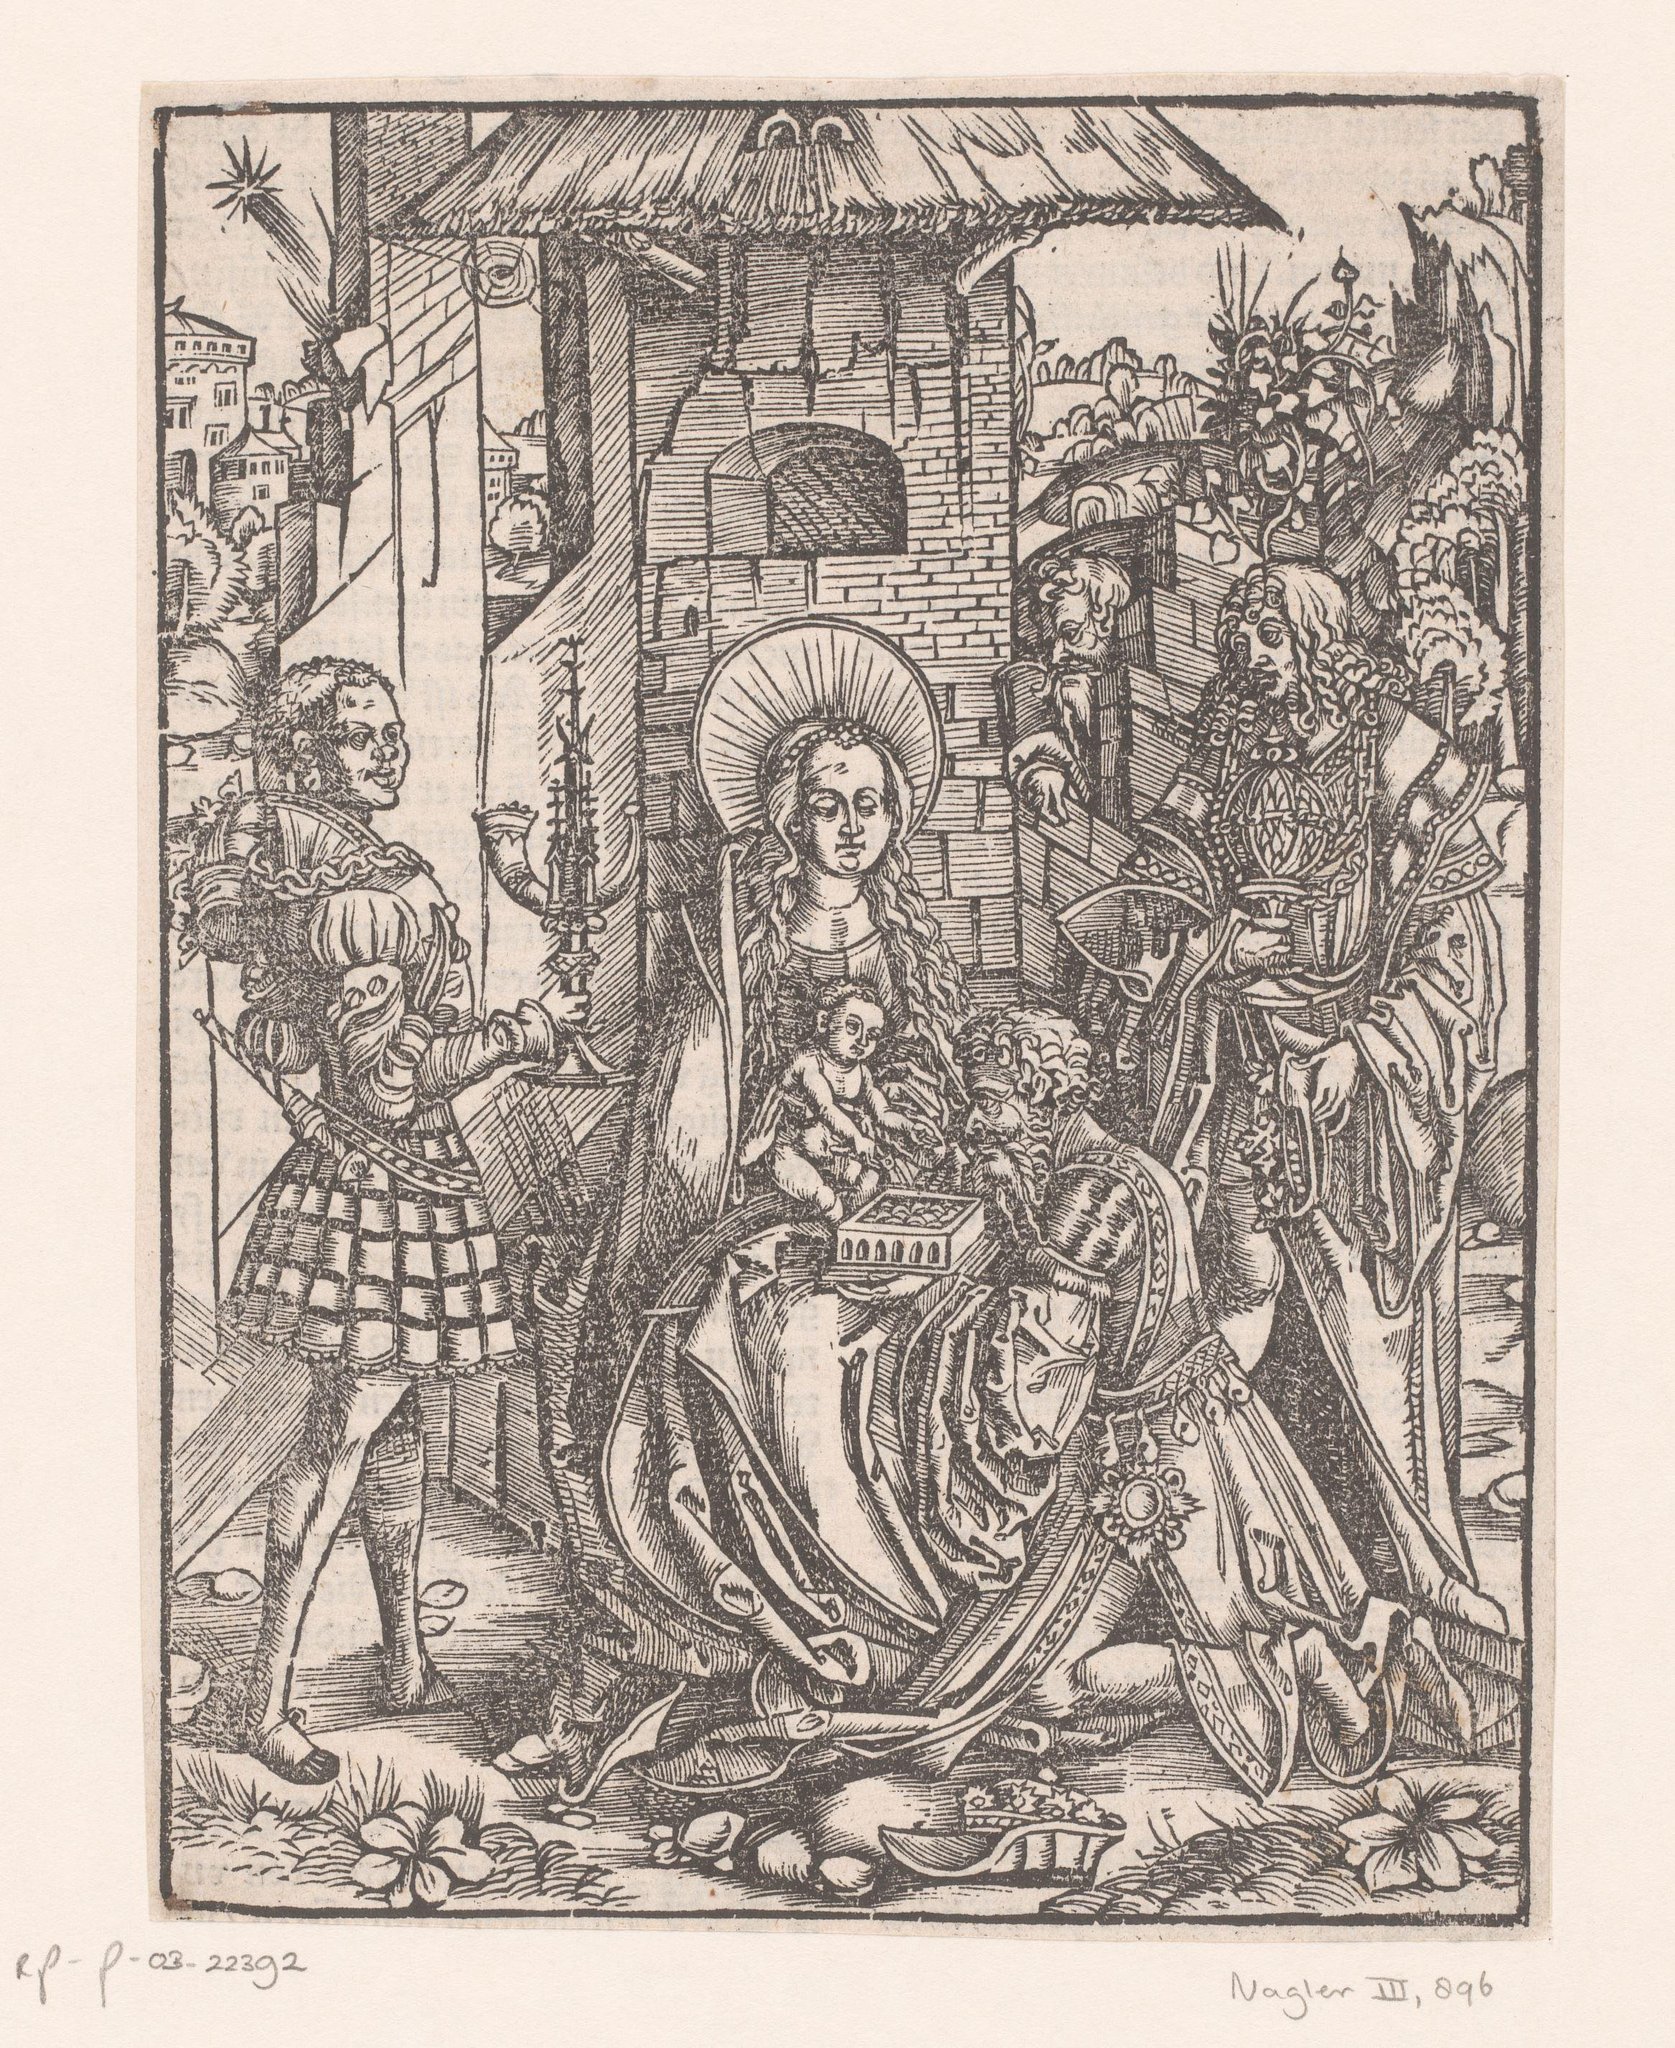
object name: book illustration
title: Aanbidding der koningen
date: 1517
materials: paper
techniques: woodcut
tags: adoration of the kings: the wise men present their gifts to the christ-child (gold, frankincense and myrrh)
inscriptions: collector's mark: Lugt 240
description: Prent mogelijk afkomstig uit: Evangelia mit vslegung. Straatsburg: Johann Grüninger, 1517.